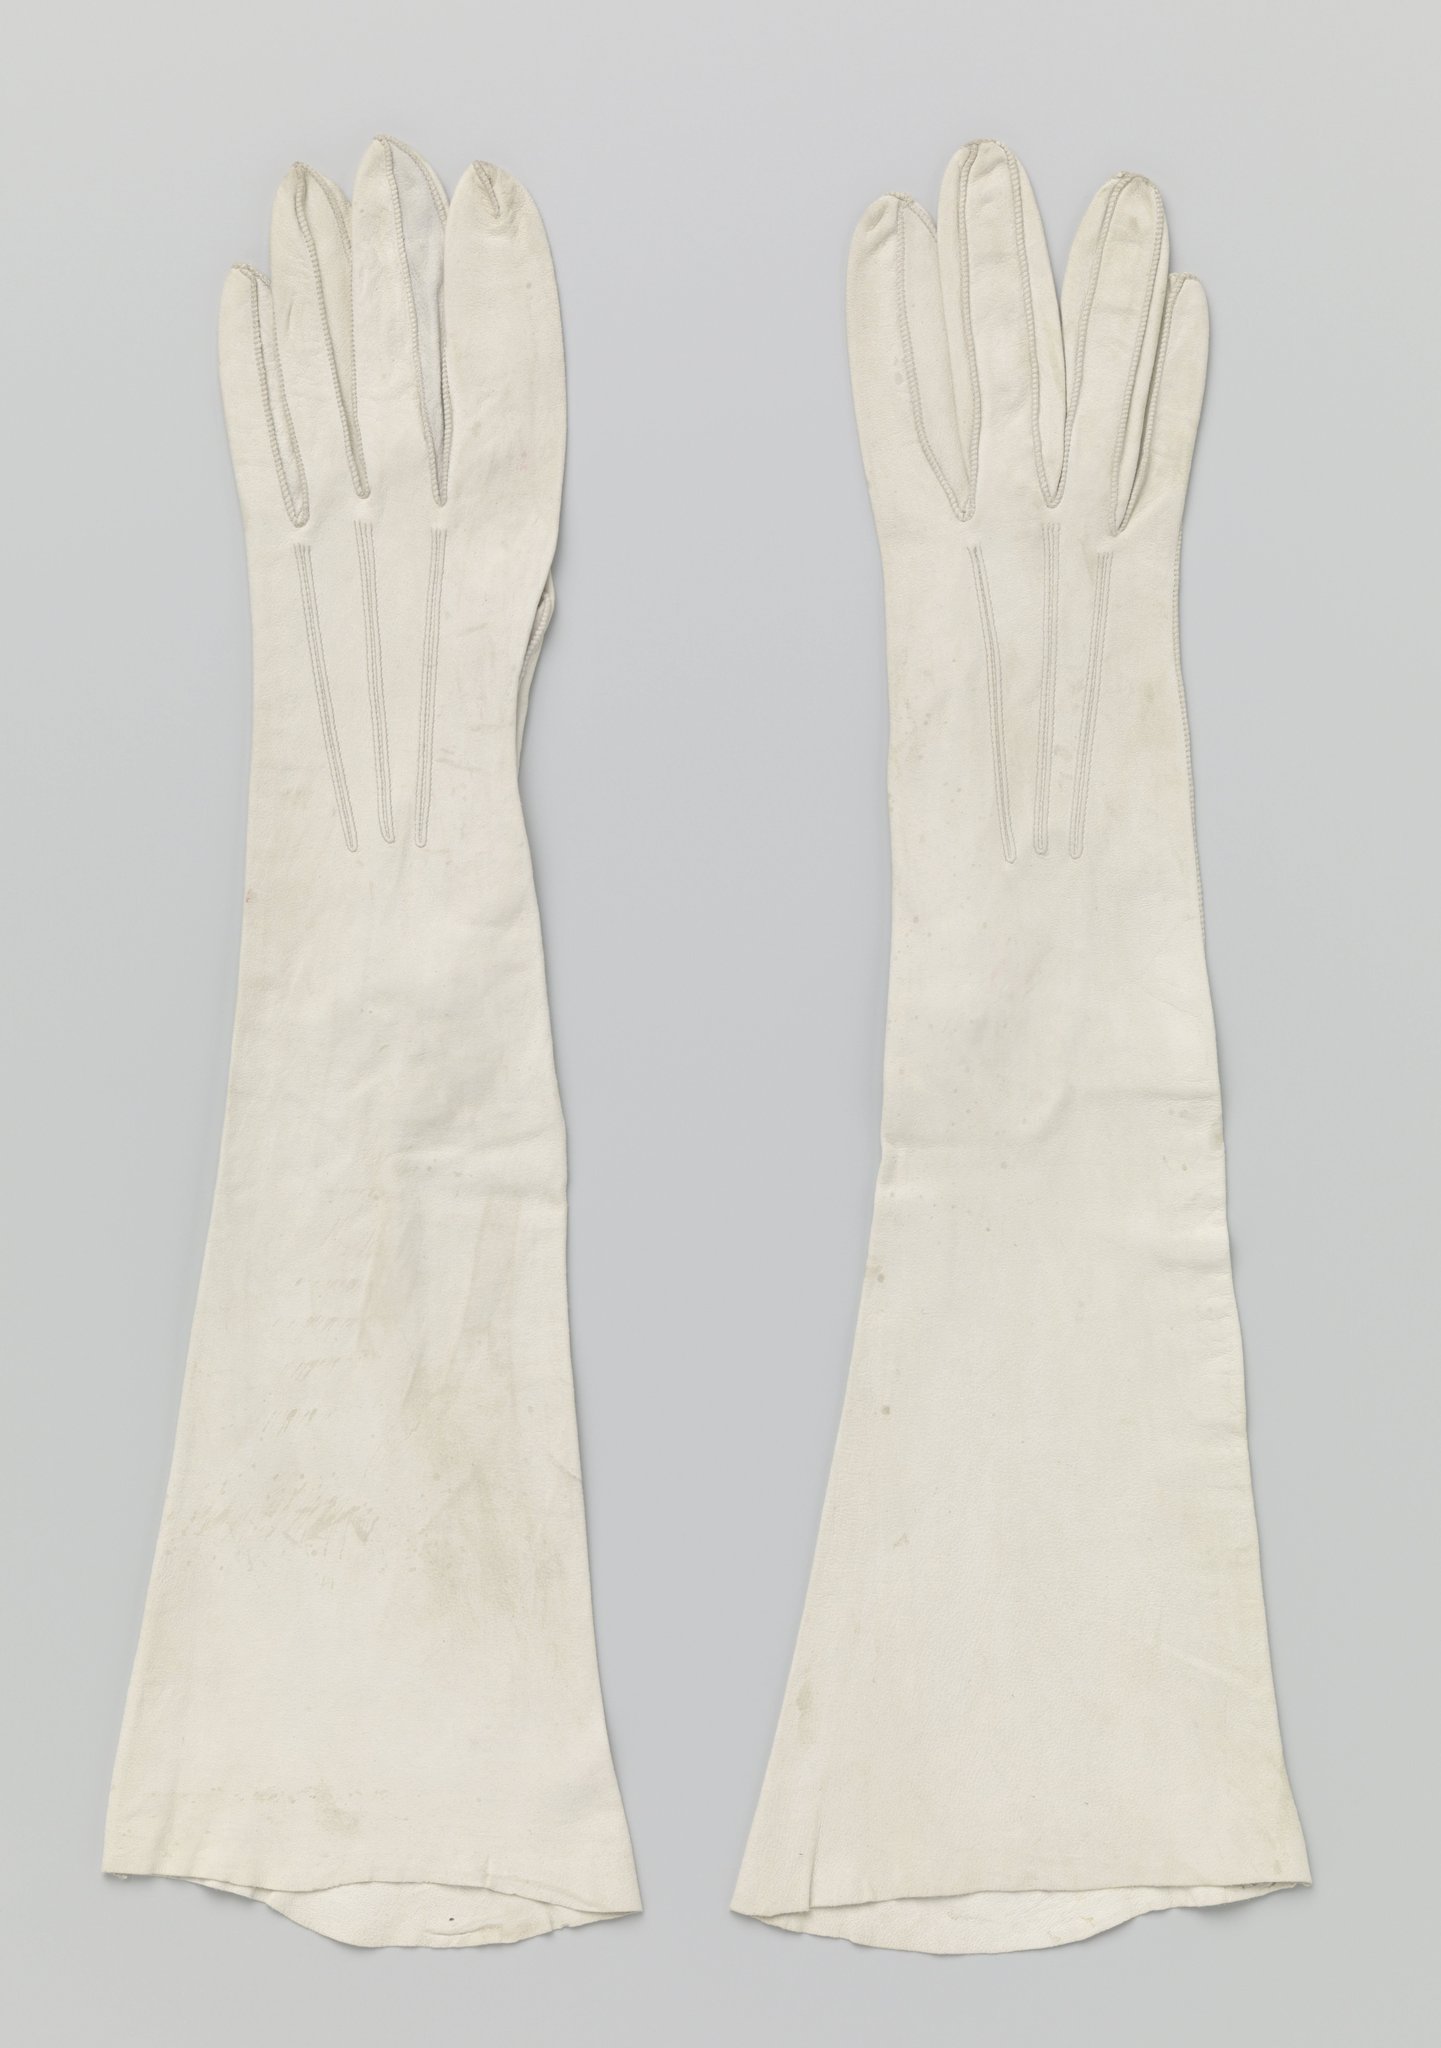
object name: glove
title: Pair of gloves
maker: Anonymous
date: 1900-1915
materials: leather, glass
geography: netherlands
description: Linker handschoen van wit zeemleer. OPde rug dire uitstralende koorden. Bij de pols een split met een witte glazen knoop.